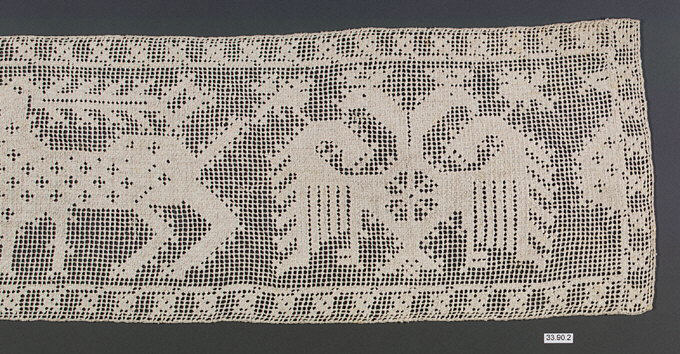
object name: border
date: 1501-1600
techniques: embroidery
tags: animals